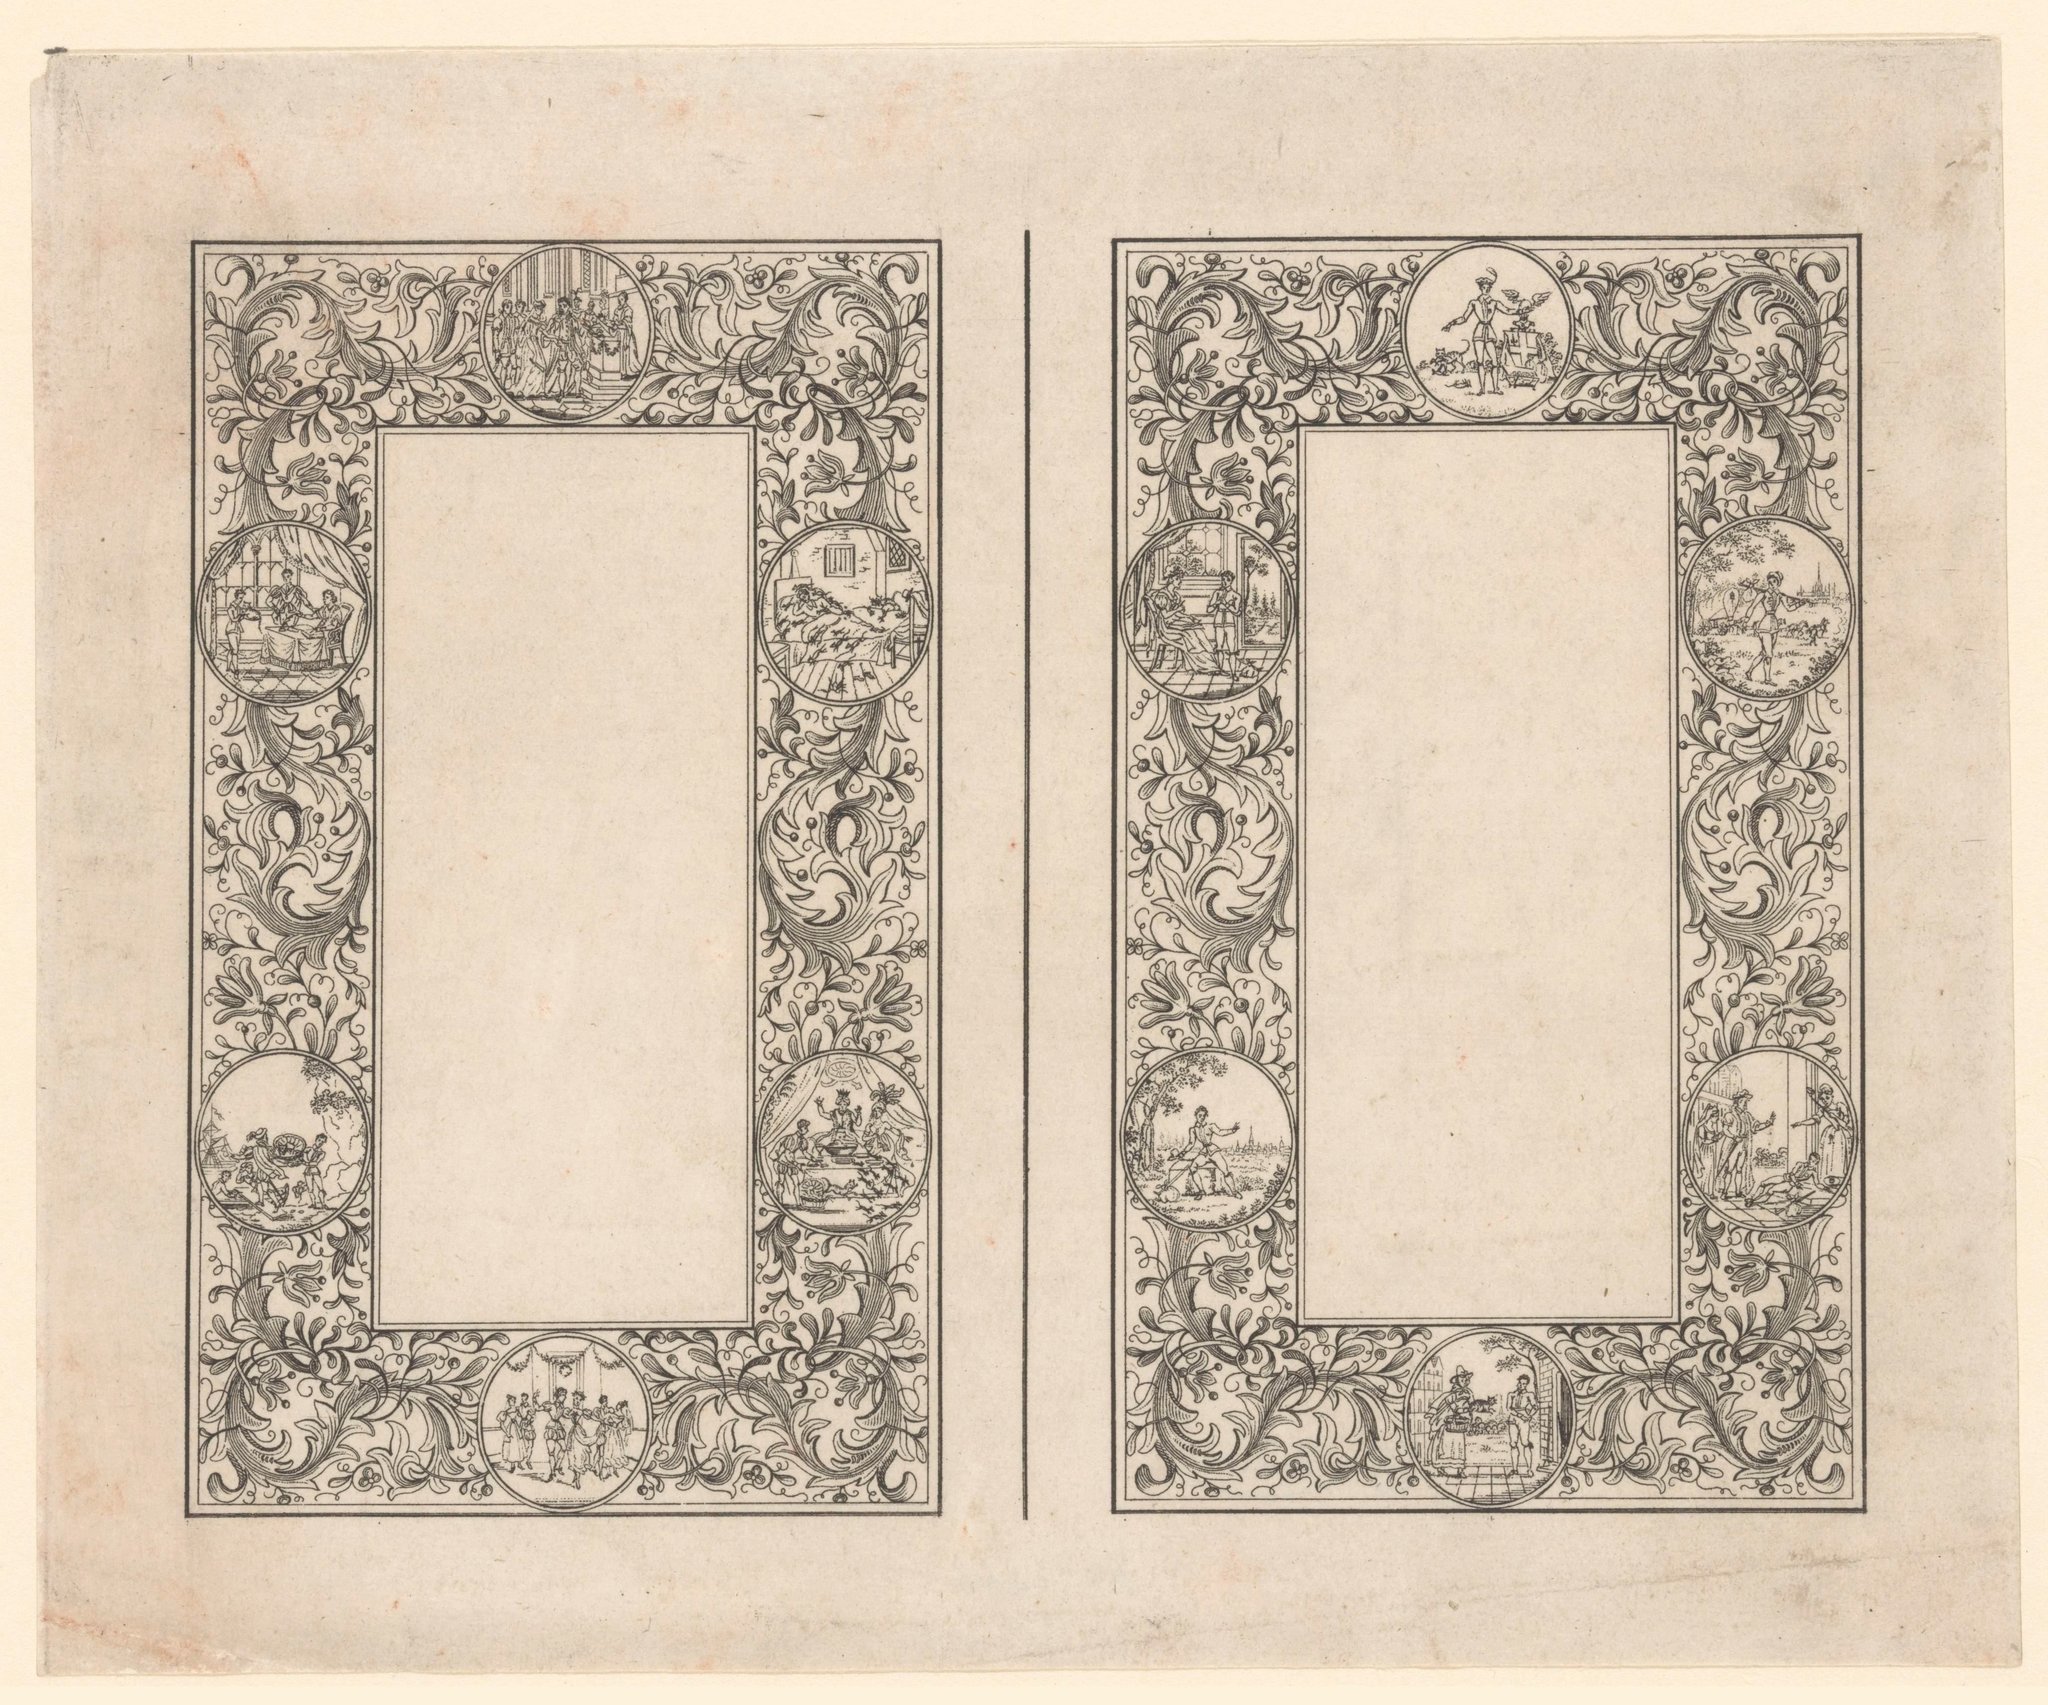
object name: ornament print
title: Omlijstingen met medaillons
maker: Anonymous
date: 1820-1840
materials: paper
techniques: etching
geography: germany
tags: ornament ~ medallion, ornaments ~ art (+ framing decorations)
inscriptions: collector's mark: Lugt 2228, collector's mark: Lugt 2760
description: Twee omlijstingen met bladmotieven en zes medaillons met scènes met figuren.